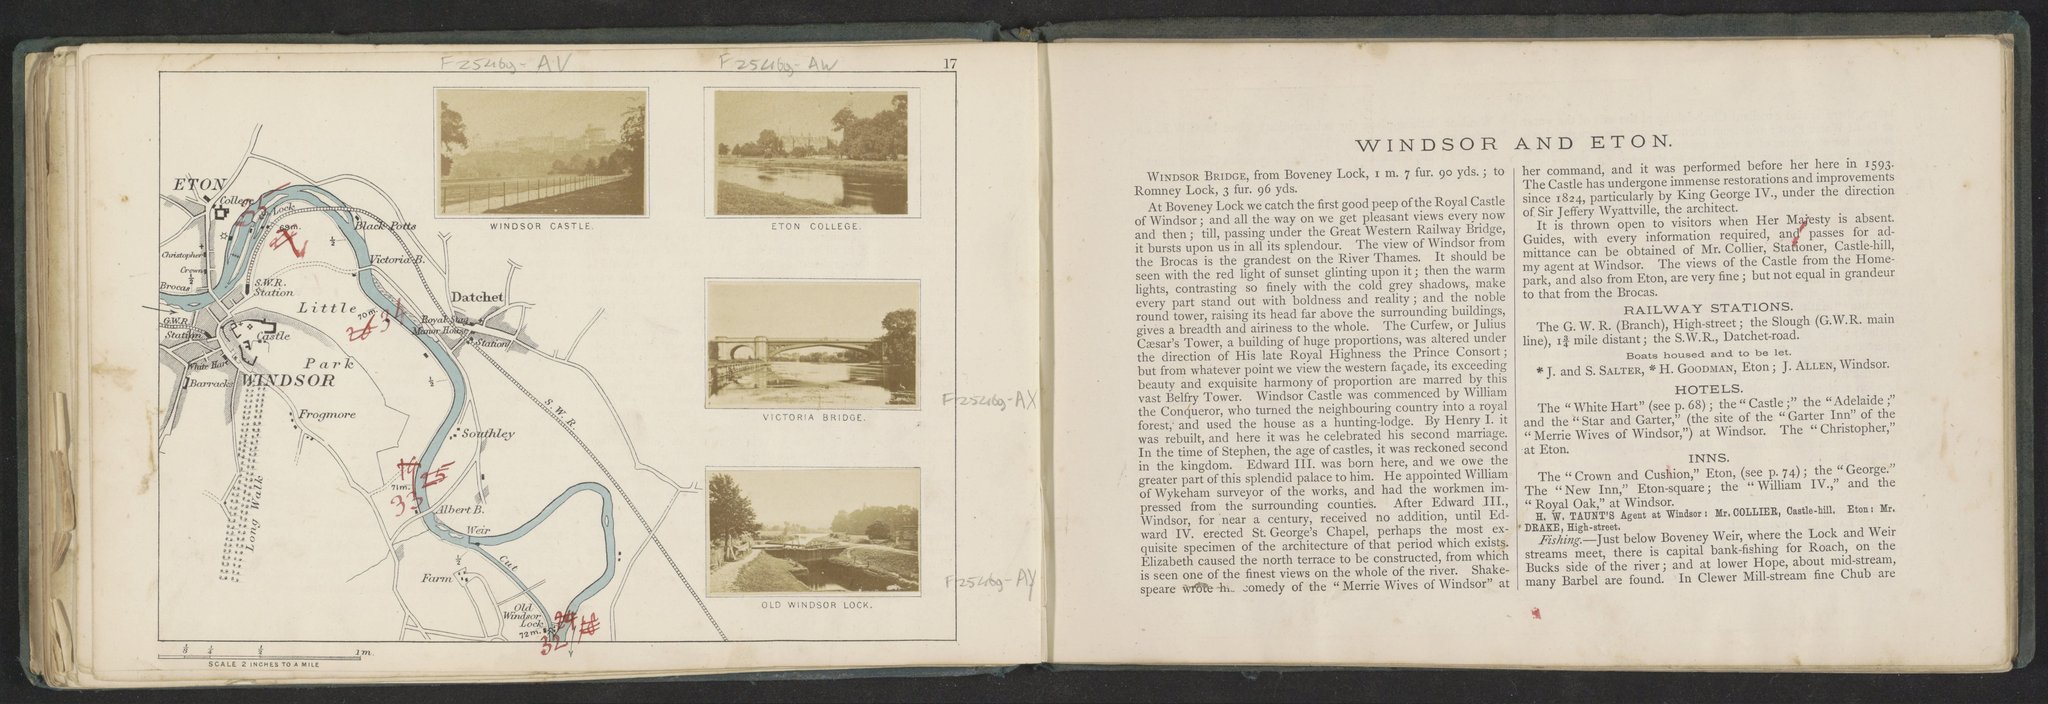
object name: photograph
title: Old Windsor Lock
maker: henry w. taunt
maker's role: fotograaf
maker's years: 1842-1922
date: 1871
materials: photographic support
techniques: albumen print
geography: old windsor lock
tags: sluice, weir, river, thames